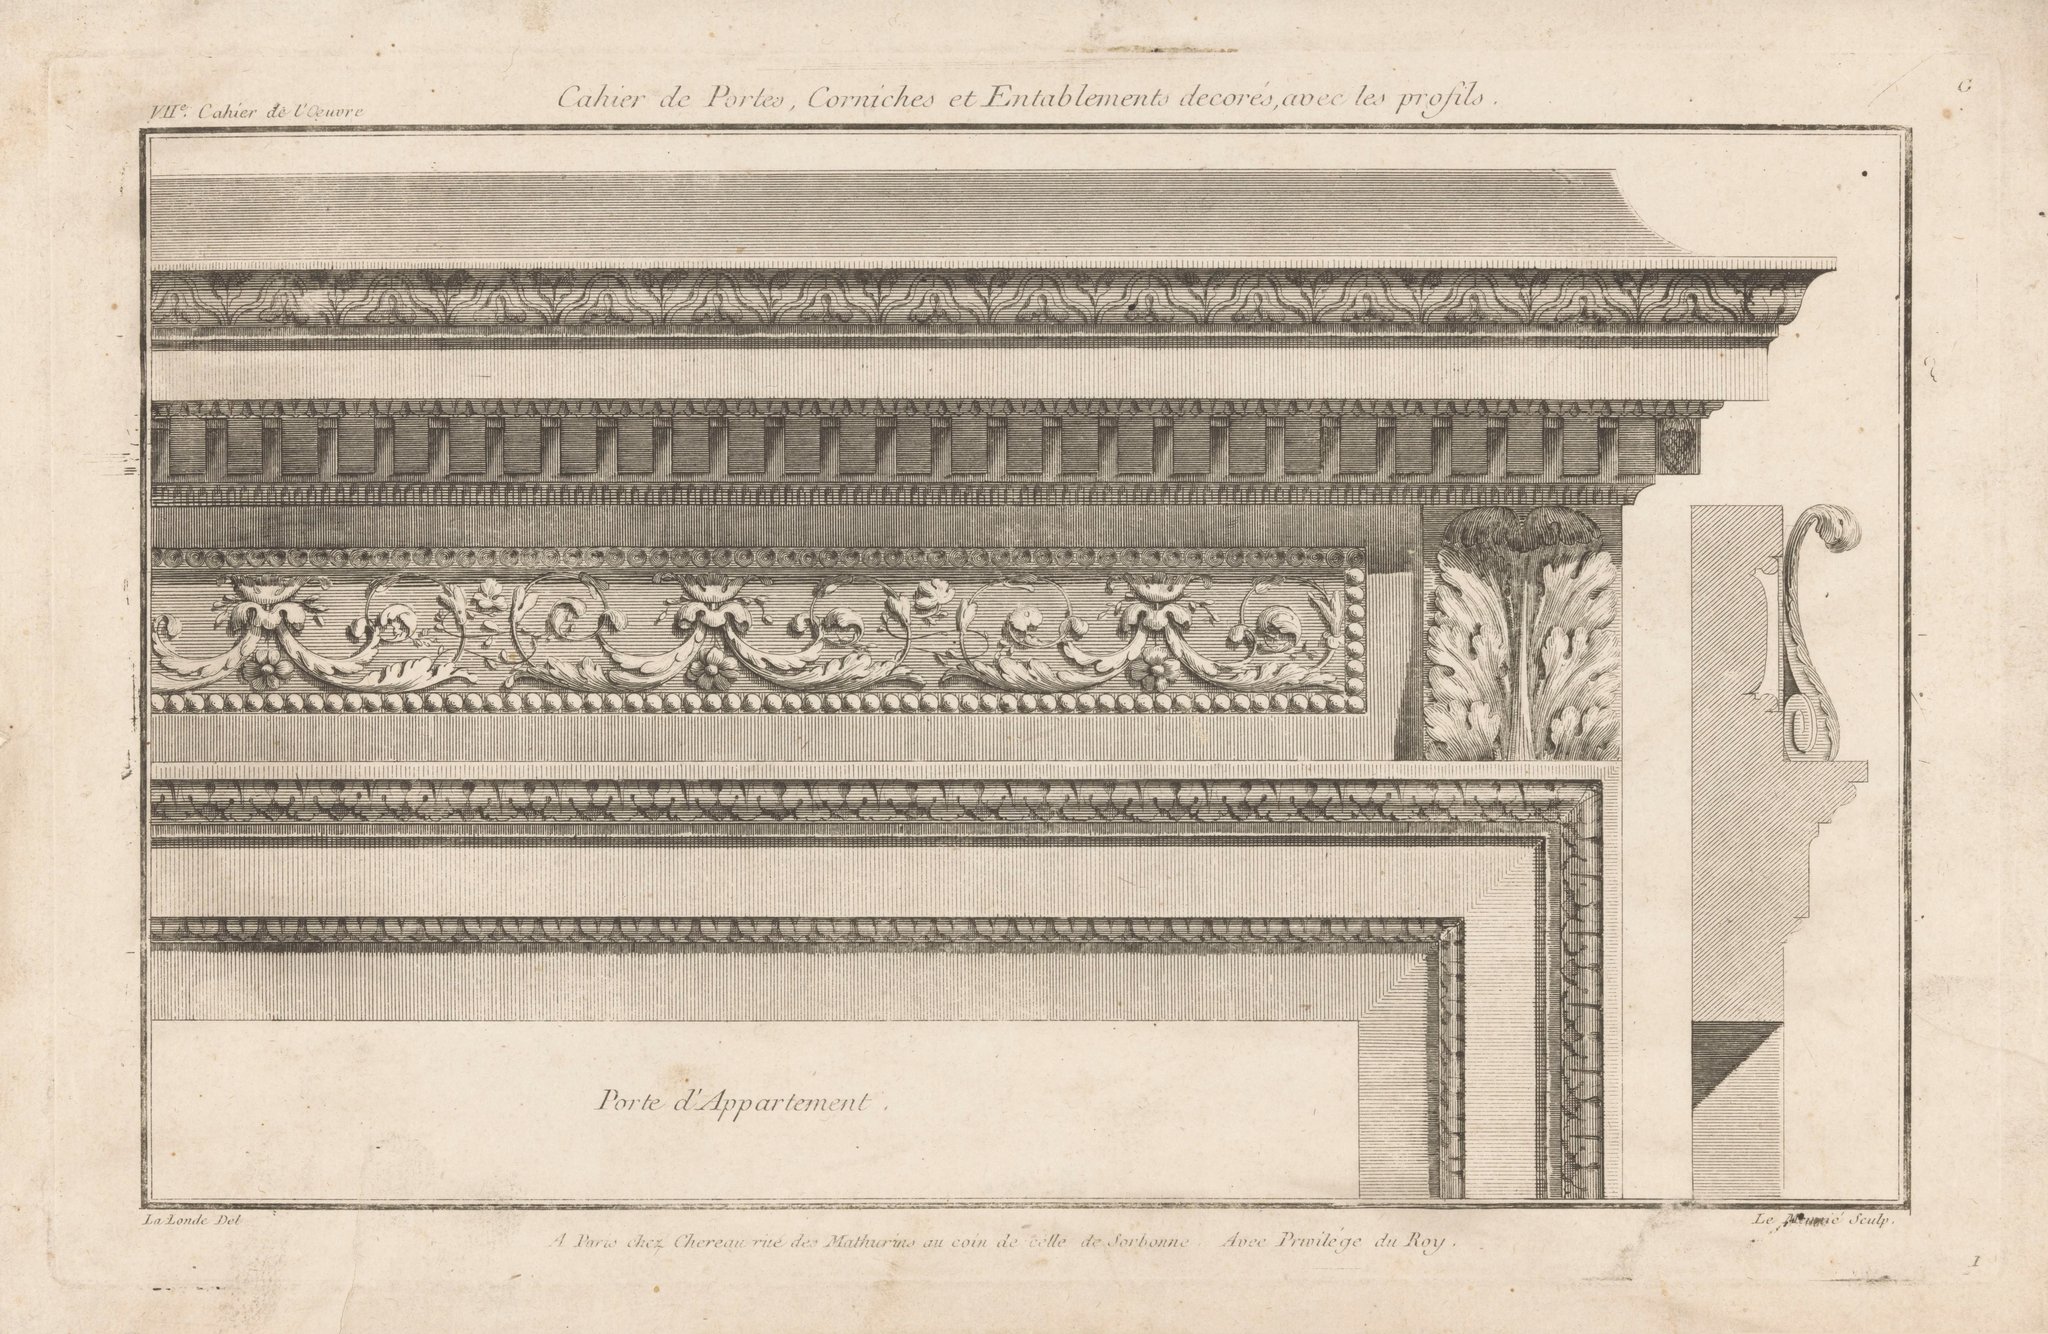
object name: titelprent, frontispice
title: VIIe Cahier de l'Oeuvre G Cahier de Portes, Corniches et Entablements decorés, aves les profils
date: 1784-1785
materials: paper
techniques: engraving, etching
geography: paris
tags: ornaments ~ art (+ framing decorations), door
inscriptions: collector's mark: Lugt 2760, collector's mark: Lugt 2228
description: Vooraanzicht en profiel van een geornamenteerde deurlijst met vlechtwerk en acanthusbladeren.